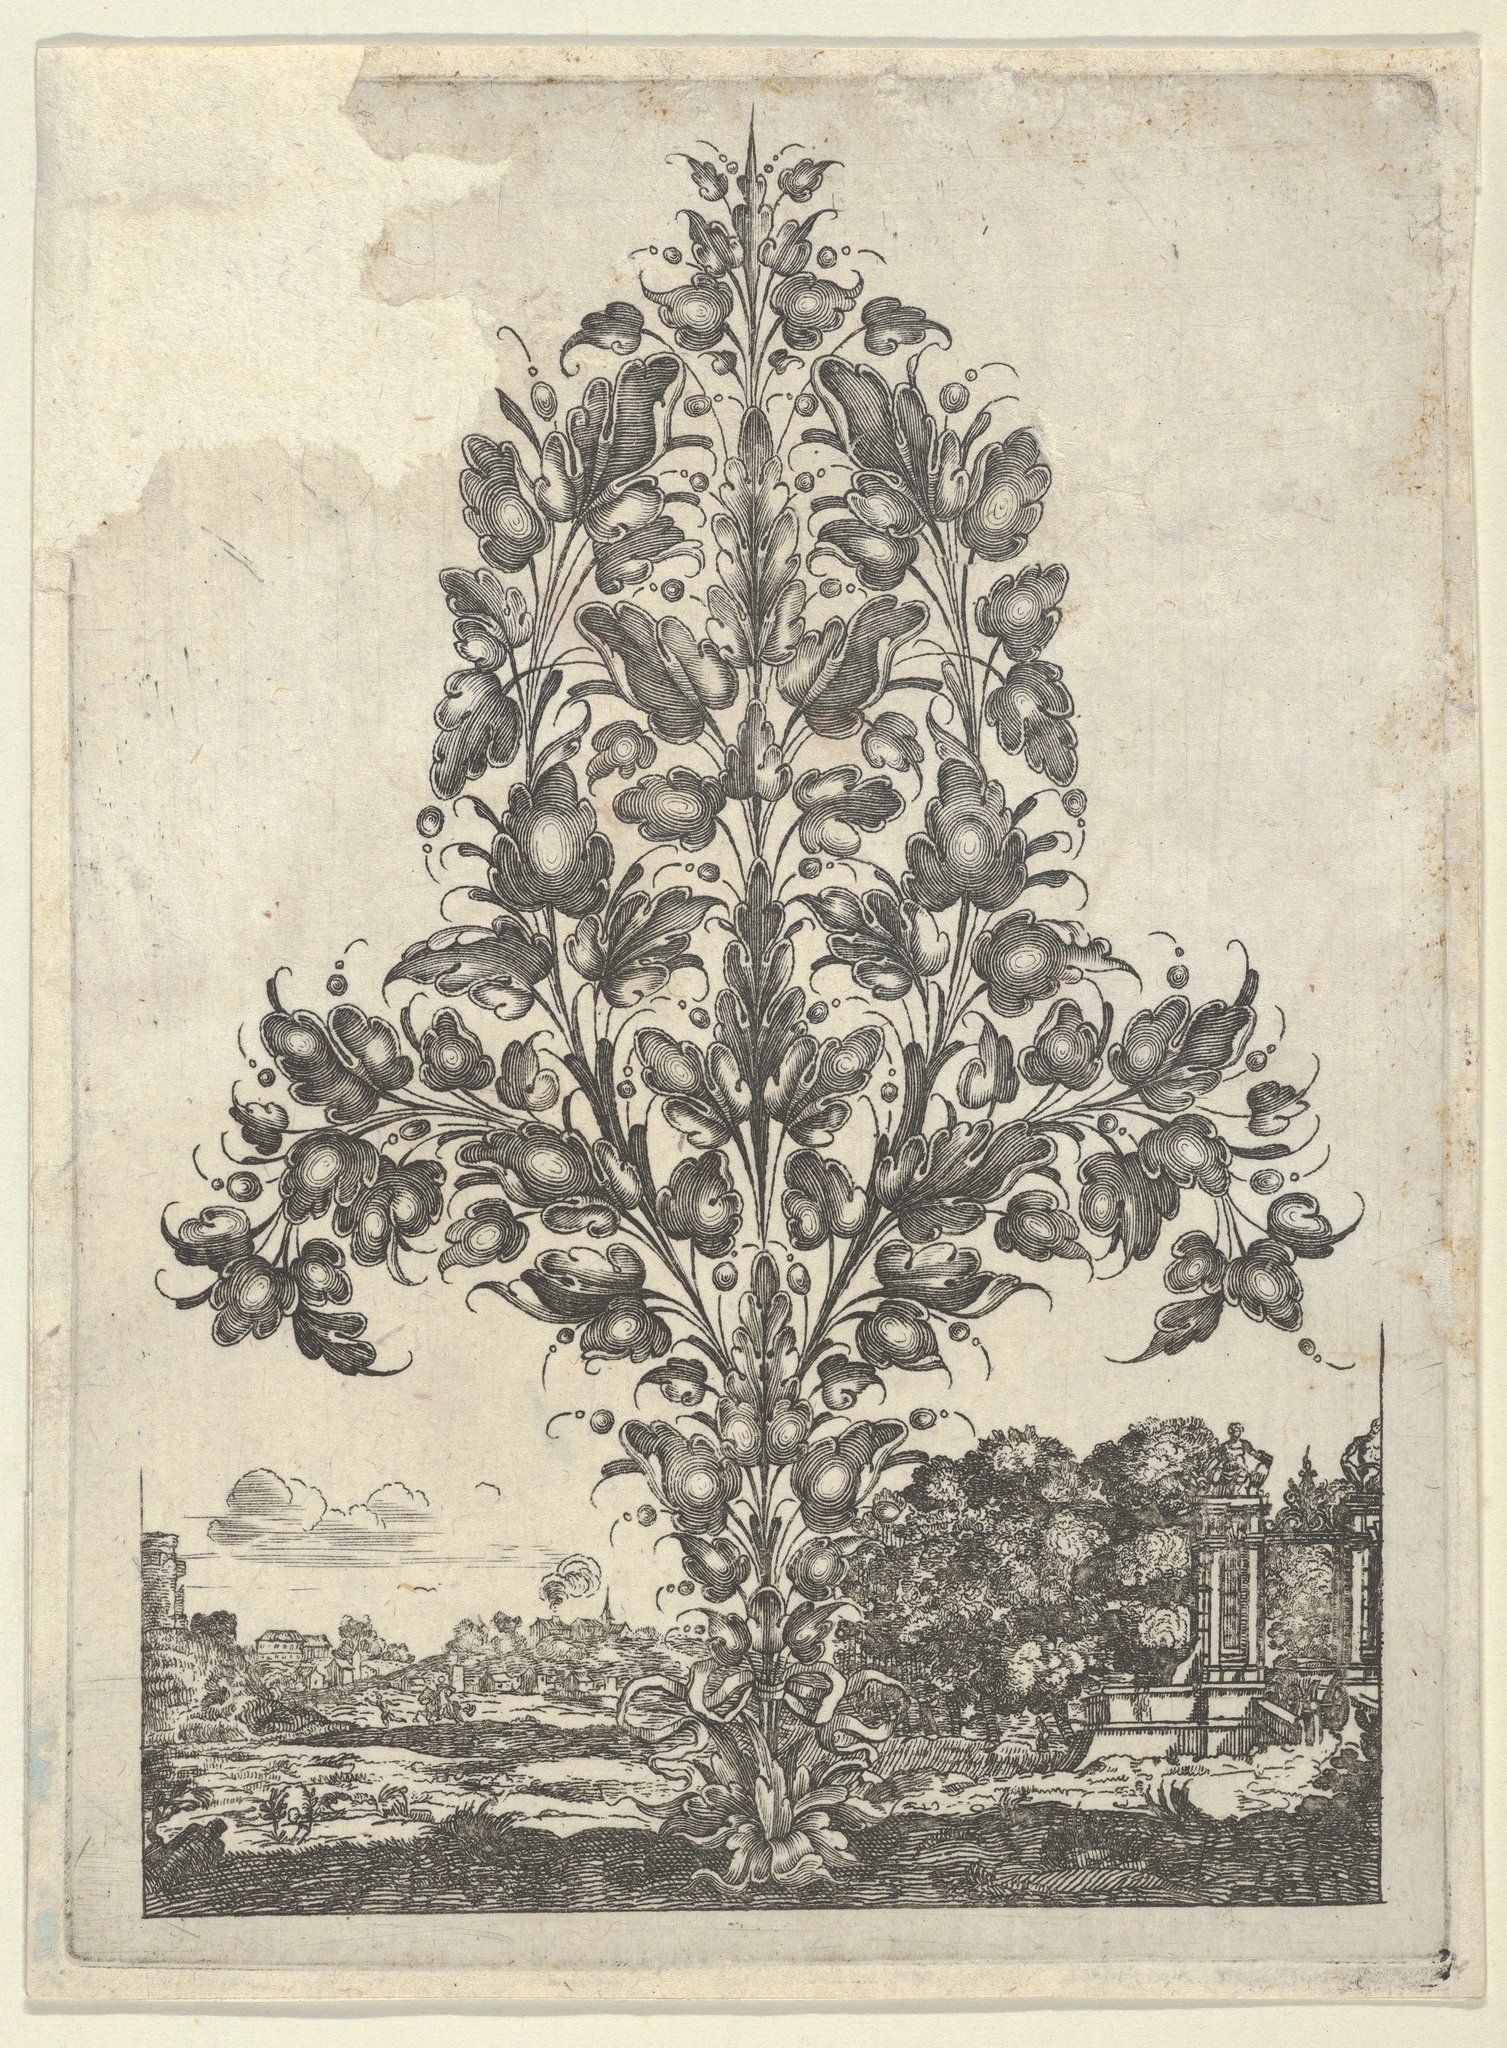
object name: print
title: Goldsmith's Bouquet, from "Newes Lauberbuechlein"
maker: peter aubry ii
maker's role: artist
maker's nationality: german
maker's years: 1610-1666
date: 1628-1666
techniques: engraving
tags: flowers